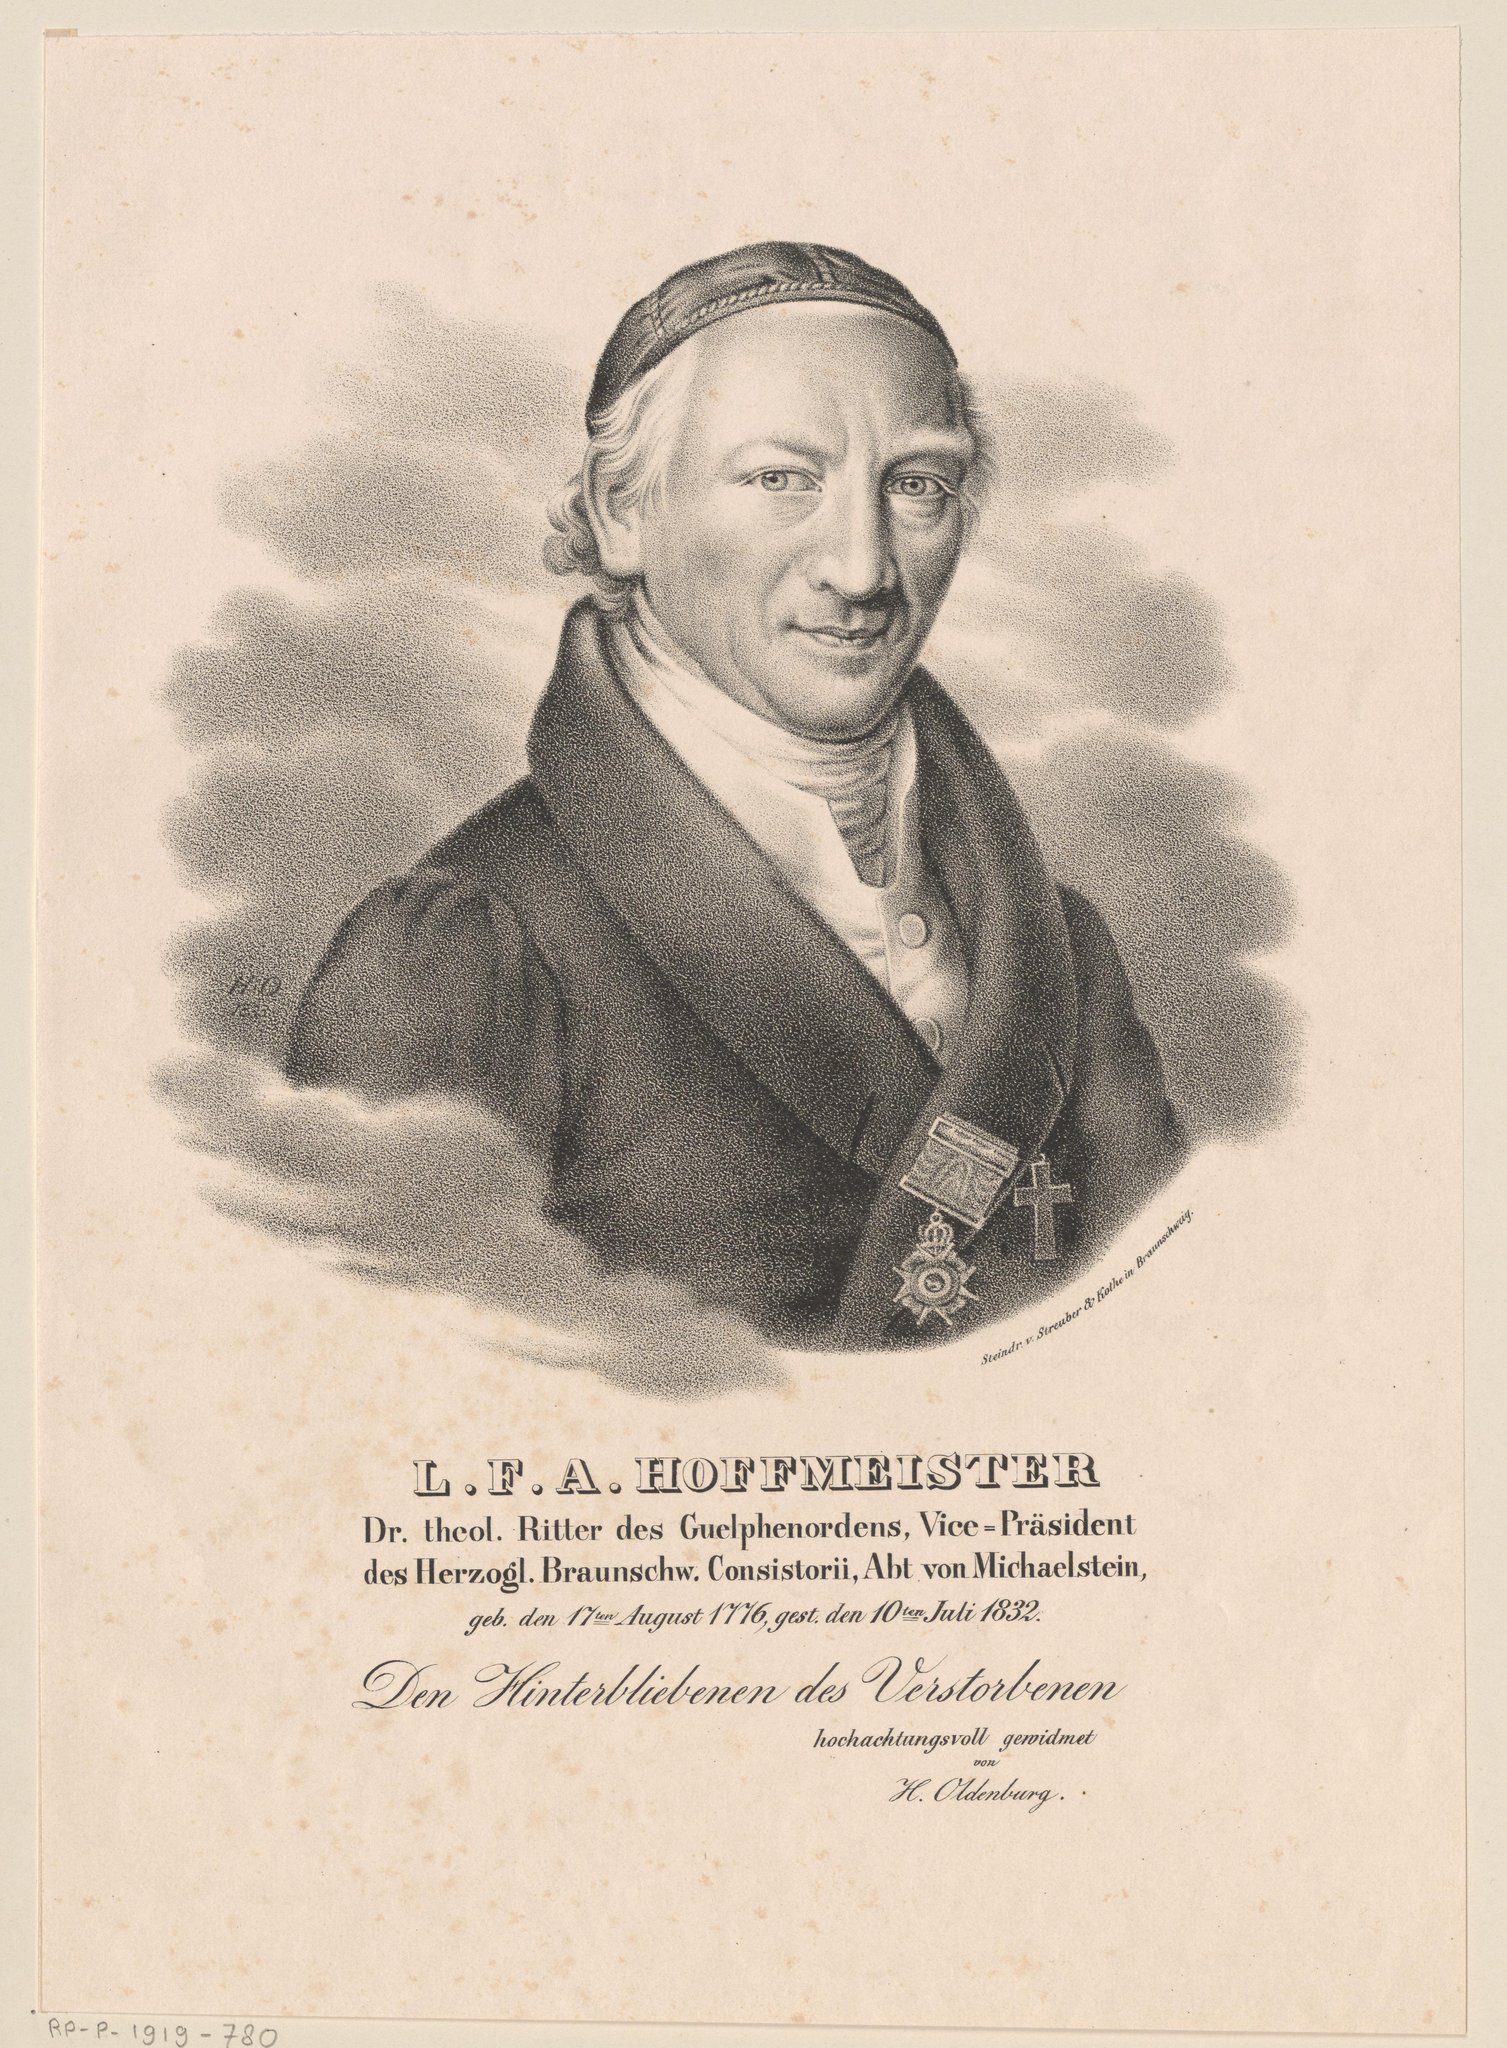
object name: print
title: Portret van Ludwig Friedrich August Hoffmeister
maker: h. oldenburg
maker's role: print maker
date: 1833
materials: paper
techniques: lithograph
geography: braunschweig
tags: theologian, historical persons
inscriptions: collector's mark: Lugt 2228